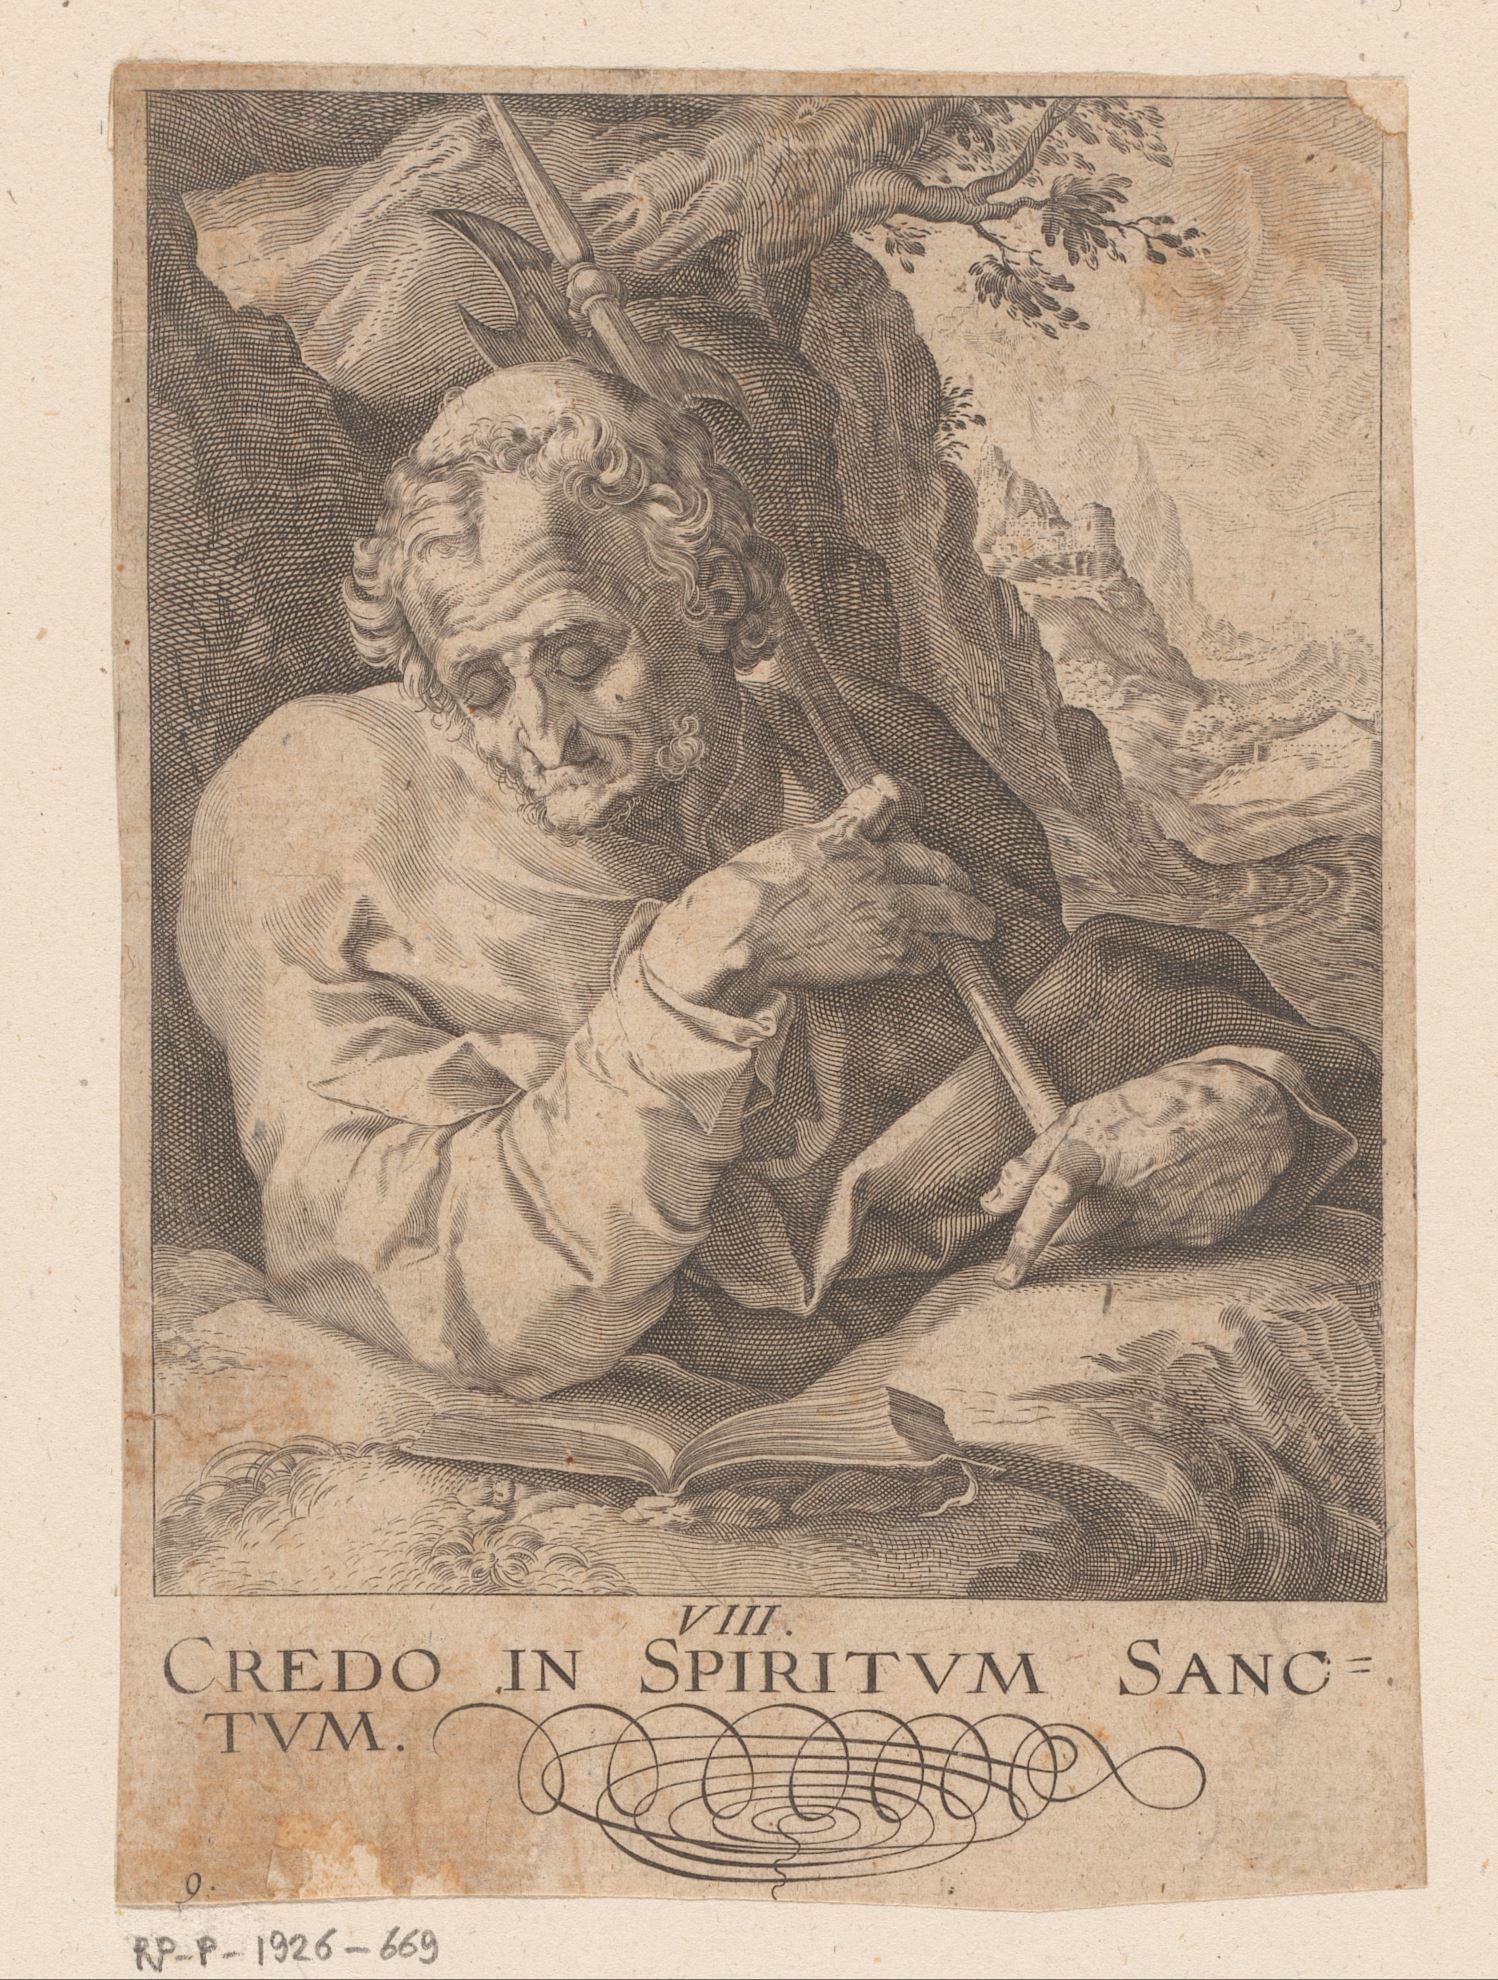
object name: print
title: Apostel Mattheüs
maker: jacques granthomme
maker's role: print maker, publisher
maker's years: 1550-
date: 1588-1622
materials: paper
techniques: engraving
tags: the apostle and evangelist matthew (mattheus); possible attributes: angel, axe, book, halberd, pen and inkhorn, purse, scroll, square, sword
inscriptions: collector's mark: Lugt 1432, collector's mark: Lugt 2166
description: Maakt deel uit van een dertiendelige serie van Christus en de twaalf apostelen naar Hendrick Goltzius.